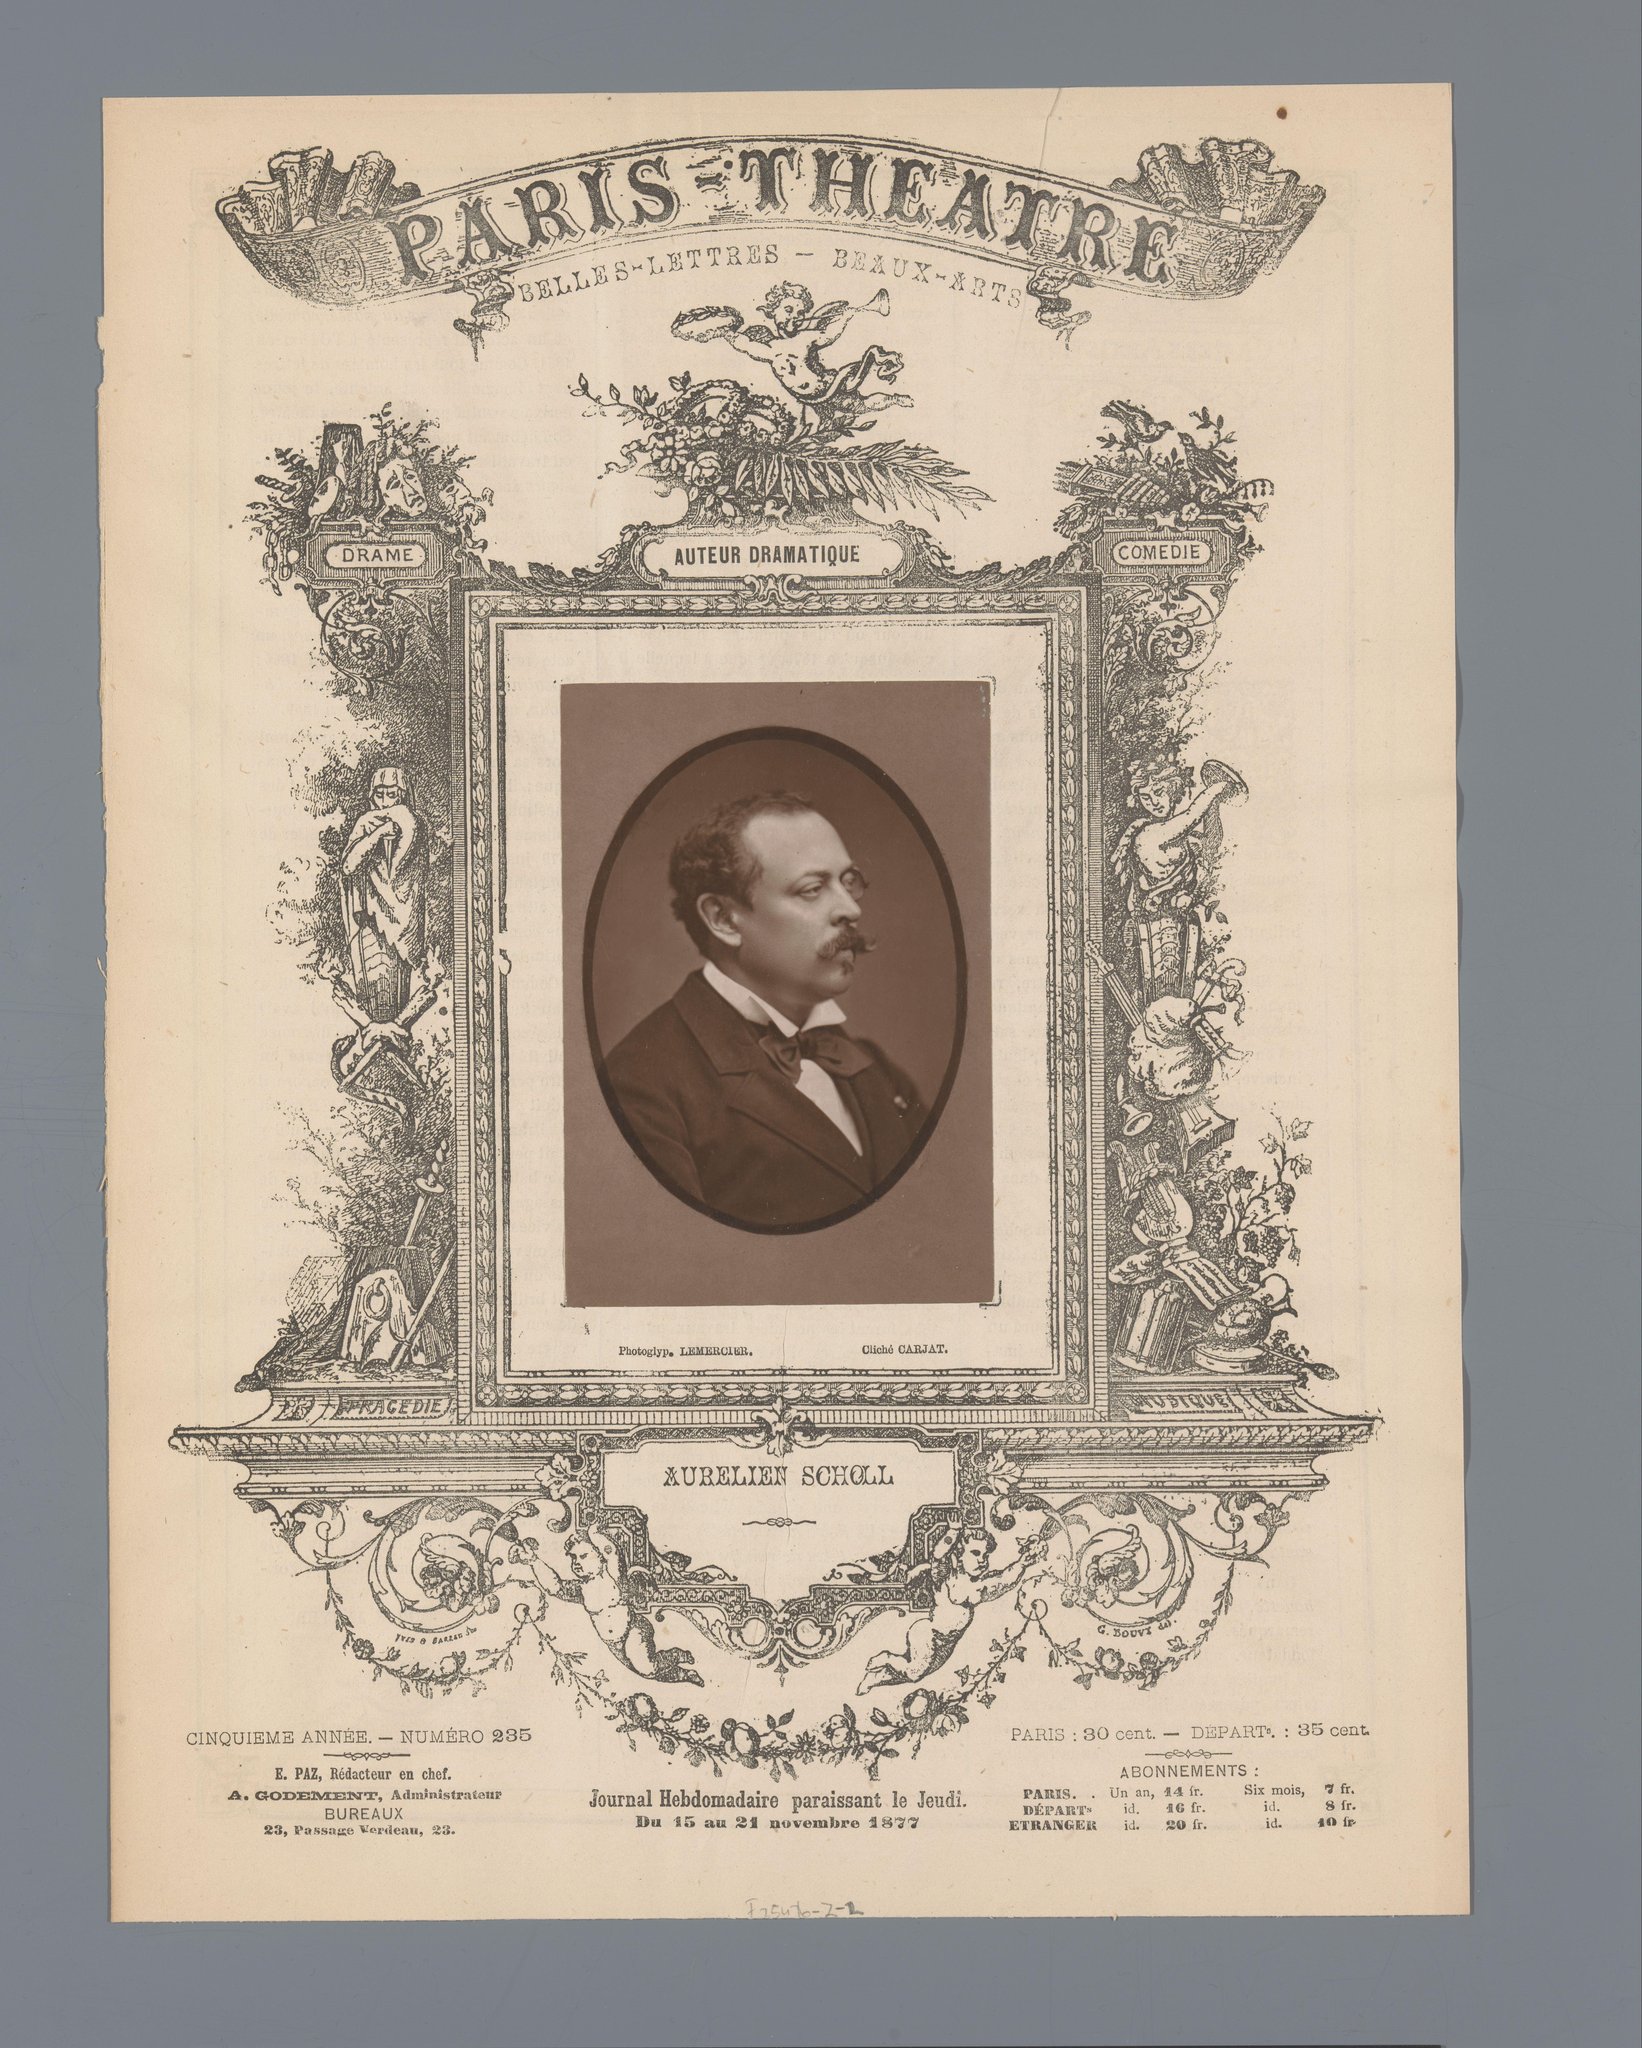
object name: photomechanical print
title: Aurélien Scholl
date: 1872-1879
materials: paper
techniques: woodburytype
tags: paris, historical persons